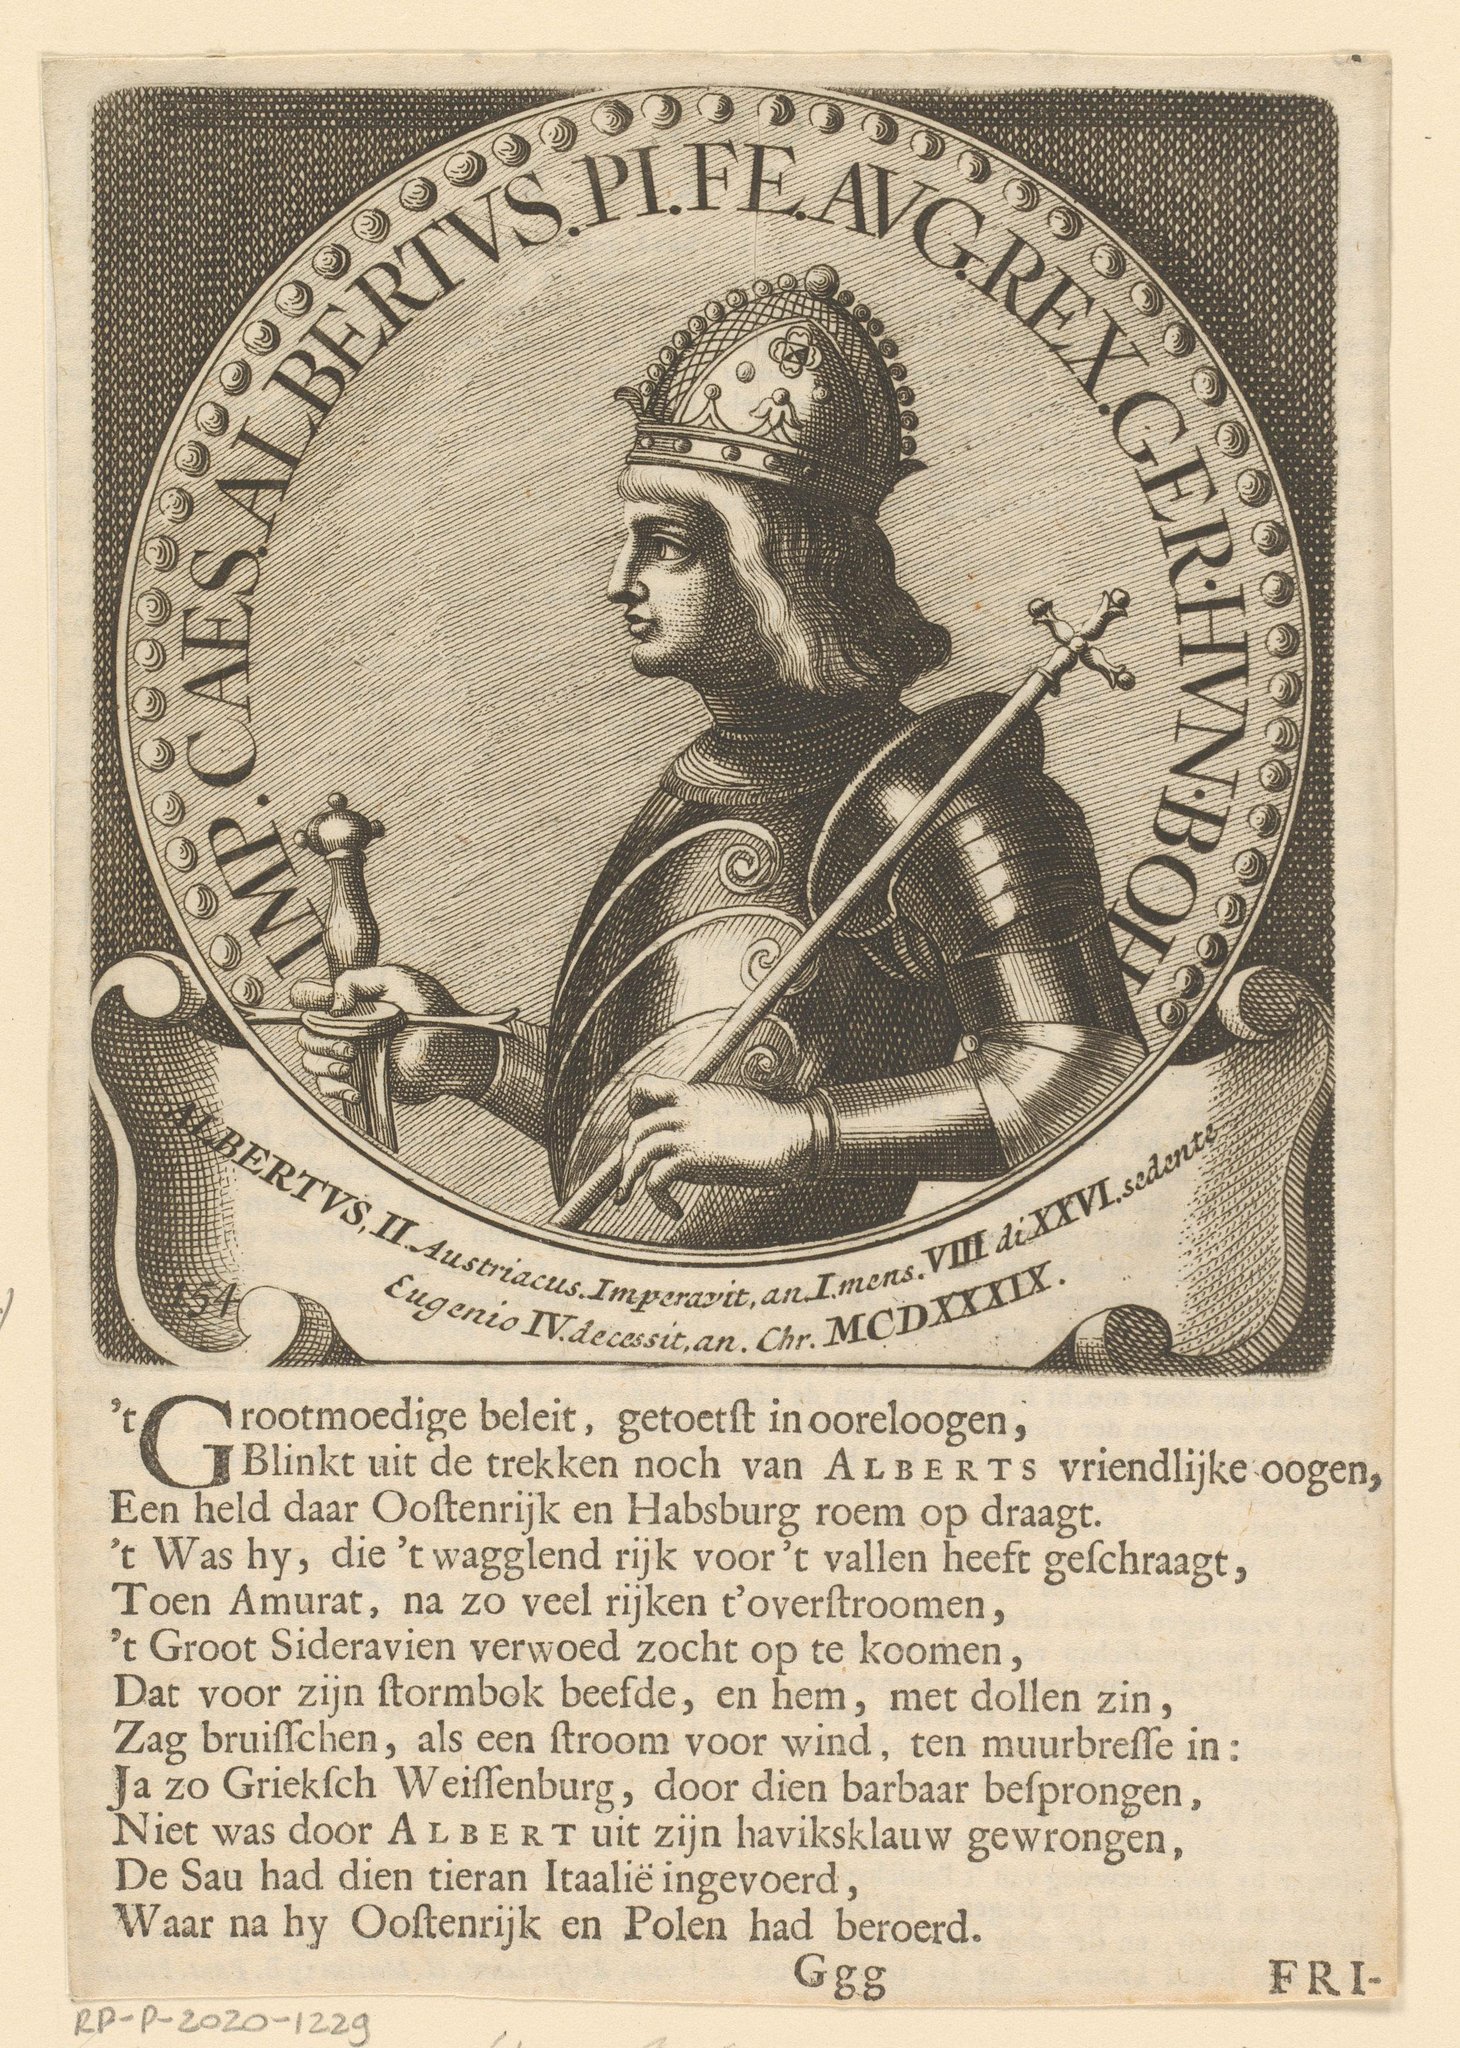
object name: book illustration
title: Imp. caes. Albertus. pi. fe. Aug. rex. Ger. Hun. Boh.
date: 1697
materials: paper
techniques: engraving, etching, letterpress printing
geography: utrecht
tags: crown (symbol of sovereignty), sceptre, staff (symbol of sovereignty), historical persons, king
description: Prent uit: Bogaert, Abraham. De Roomsche monarchy, vertoont in de muntbeelden der westersche en oostersche keizeren (...). Utrecht: François Halma en Willem van de Water, 1697, p. 417. Eerste staat verschenen als grotere prent met 12 portretten, gedateerd 1695.